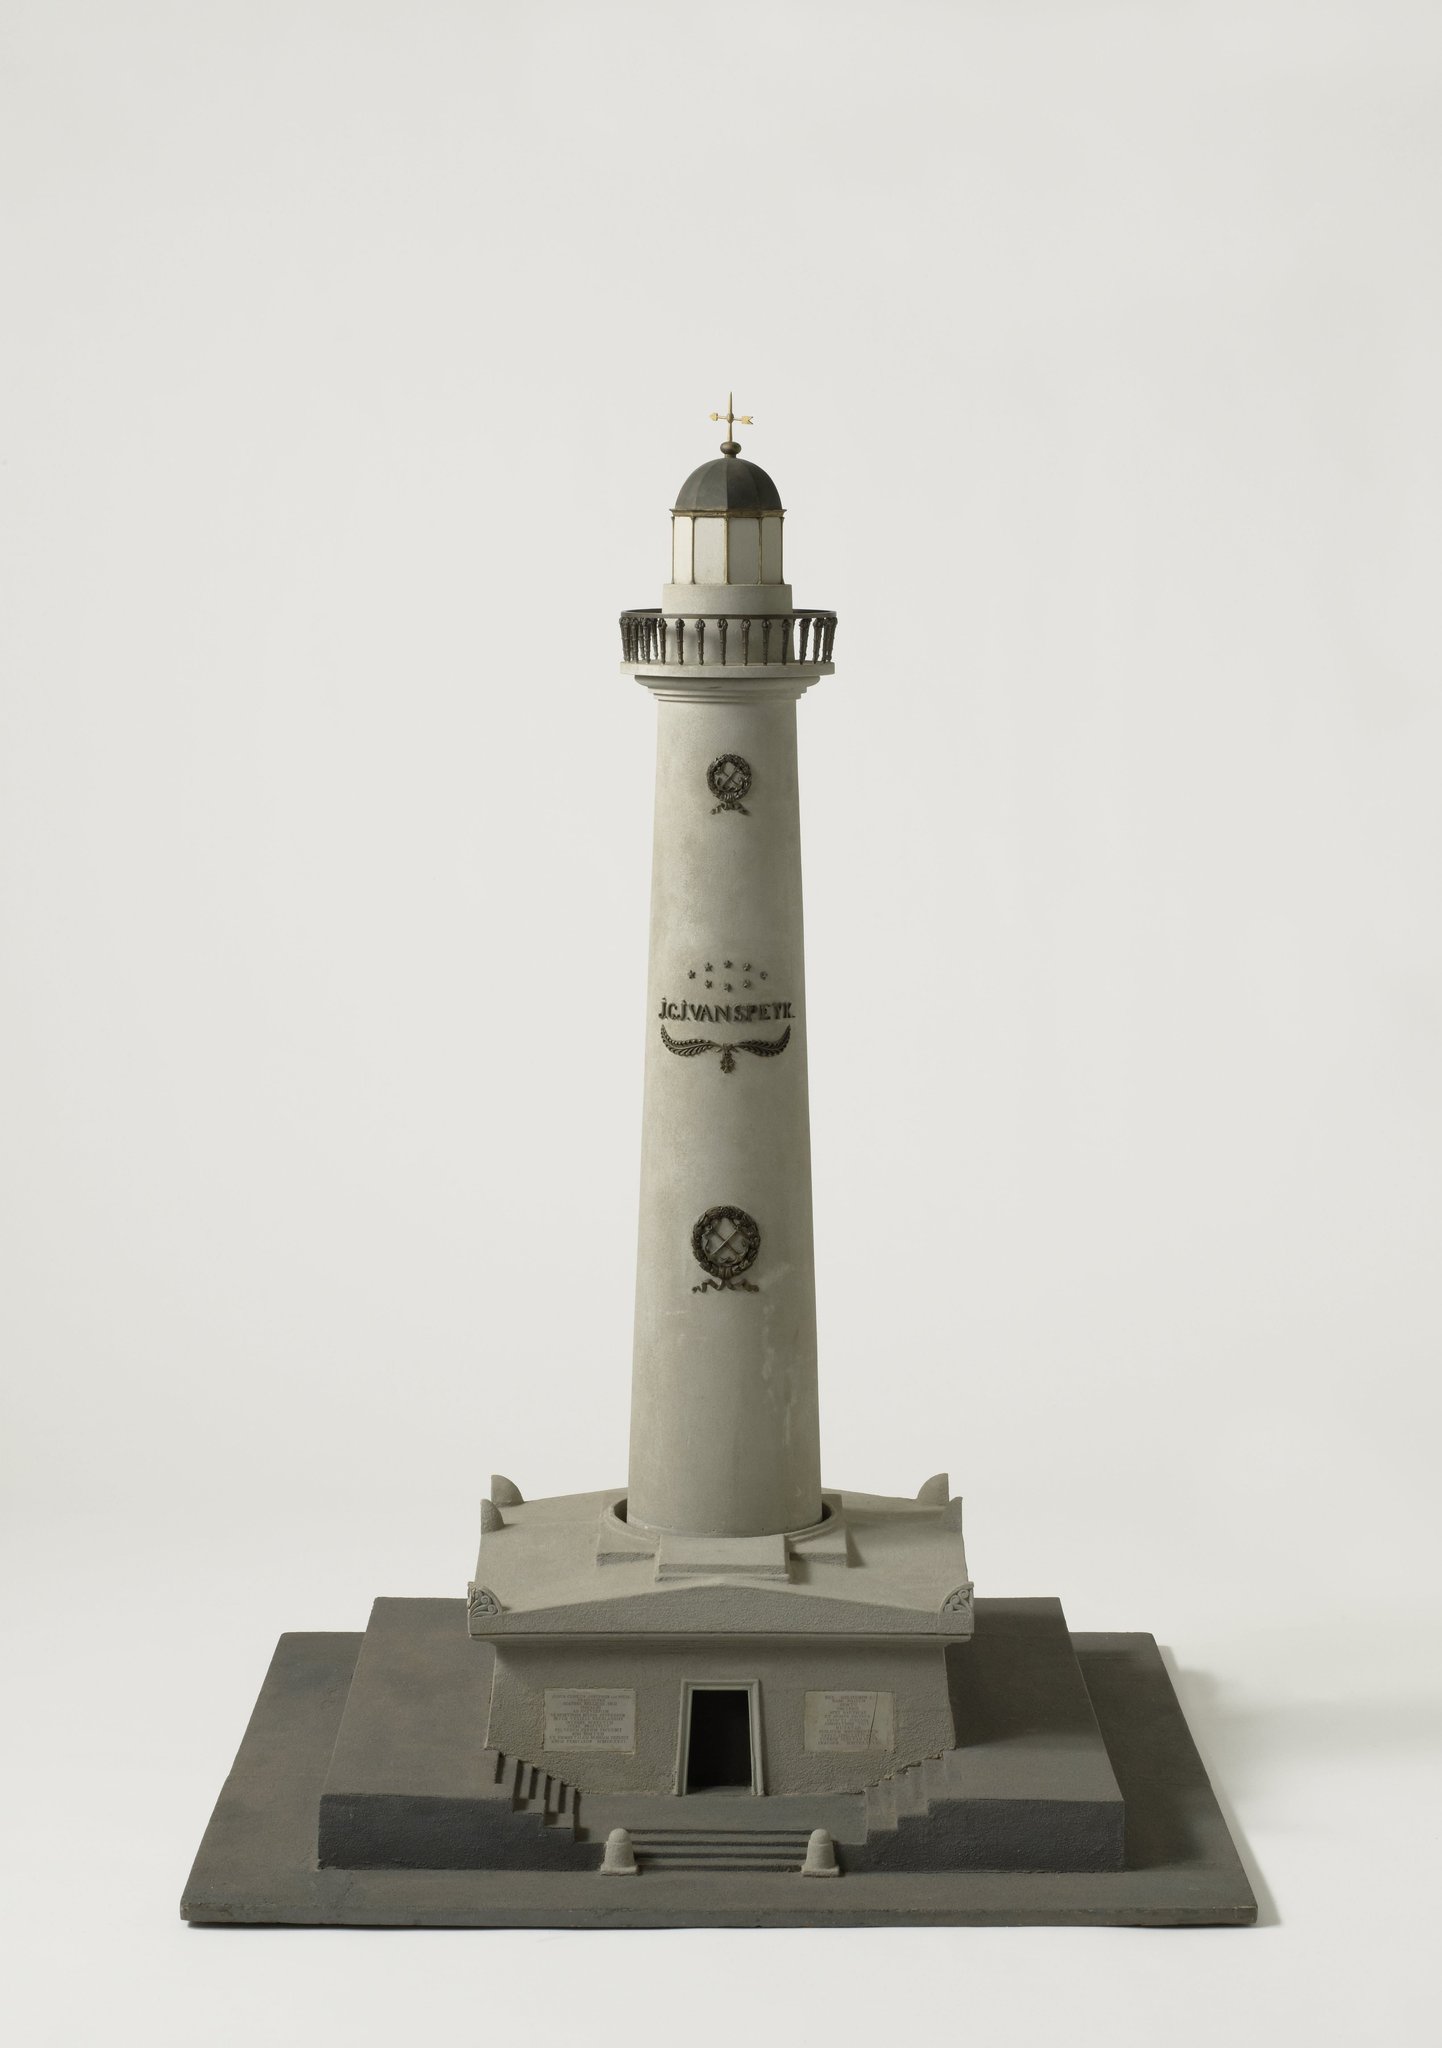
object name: show model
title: Model of a Lighthouse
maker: Anonymous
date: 1838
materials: bronze, glass, gypsum, mineral, wood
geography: netherlands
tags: amsterdam, antwerp, jan van speyk, lighthouse, lightship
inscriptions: inscription, bottom, right from the doorway: ‘REX GULIELMUS I / HANC PHARUM / SUMTU / COLLEGII / SPEI NAUTICAE / ET QUIBUS FACINUS / INVICTI JUVENIS / ADMIRATIONE FUIT / MUTATAM / PUBLICUM MONUMENTUM / FECIT APPELLAVITQUE / TURRUM JANI VAN SPEYK. / INAUGUB. MDCCCXXXVIII.’, inscription, bottom, left from the doorway: ‘JANUS CAROLUS JOSEPHUS VAN SPEYK. / PRAEFECTUS / SCAPHAE BELLICAE NO II / INSCALDI / AD ANTWERPIAM / AB SEDITIOSIS BELGIS OPPRESSUS / DECUS VEXILLI NEERLANDICI / INTEGRE SERVATYUM / VITAE PRAETULIYT / PULVERUM PYRIUM INCENDIT / SIBI MORTEM / ET IMMORTALEM GLORIAM PEPERIT / NONIS FEBRUARIS MDCCCXXXI.’, inscription, top centre: ‘j.c.j. VAN SPEYK.’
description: On 5 October 1833 the amount raised by the lottery was announced. After costs the lottery made ? 6484,98. A total of 5723 tickets had been sold and 911 prizes awarded.